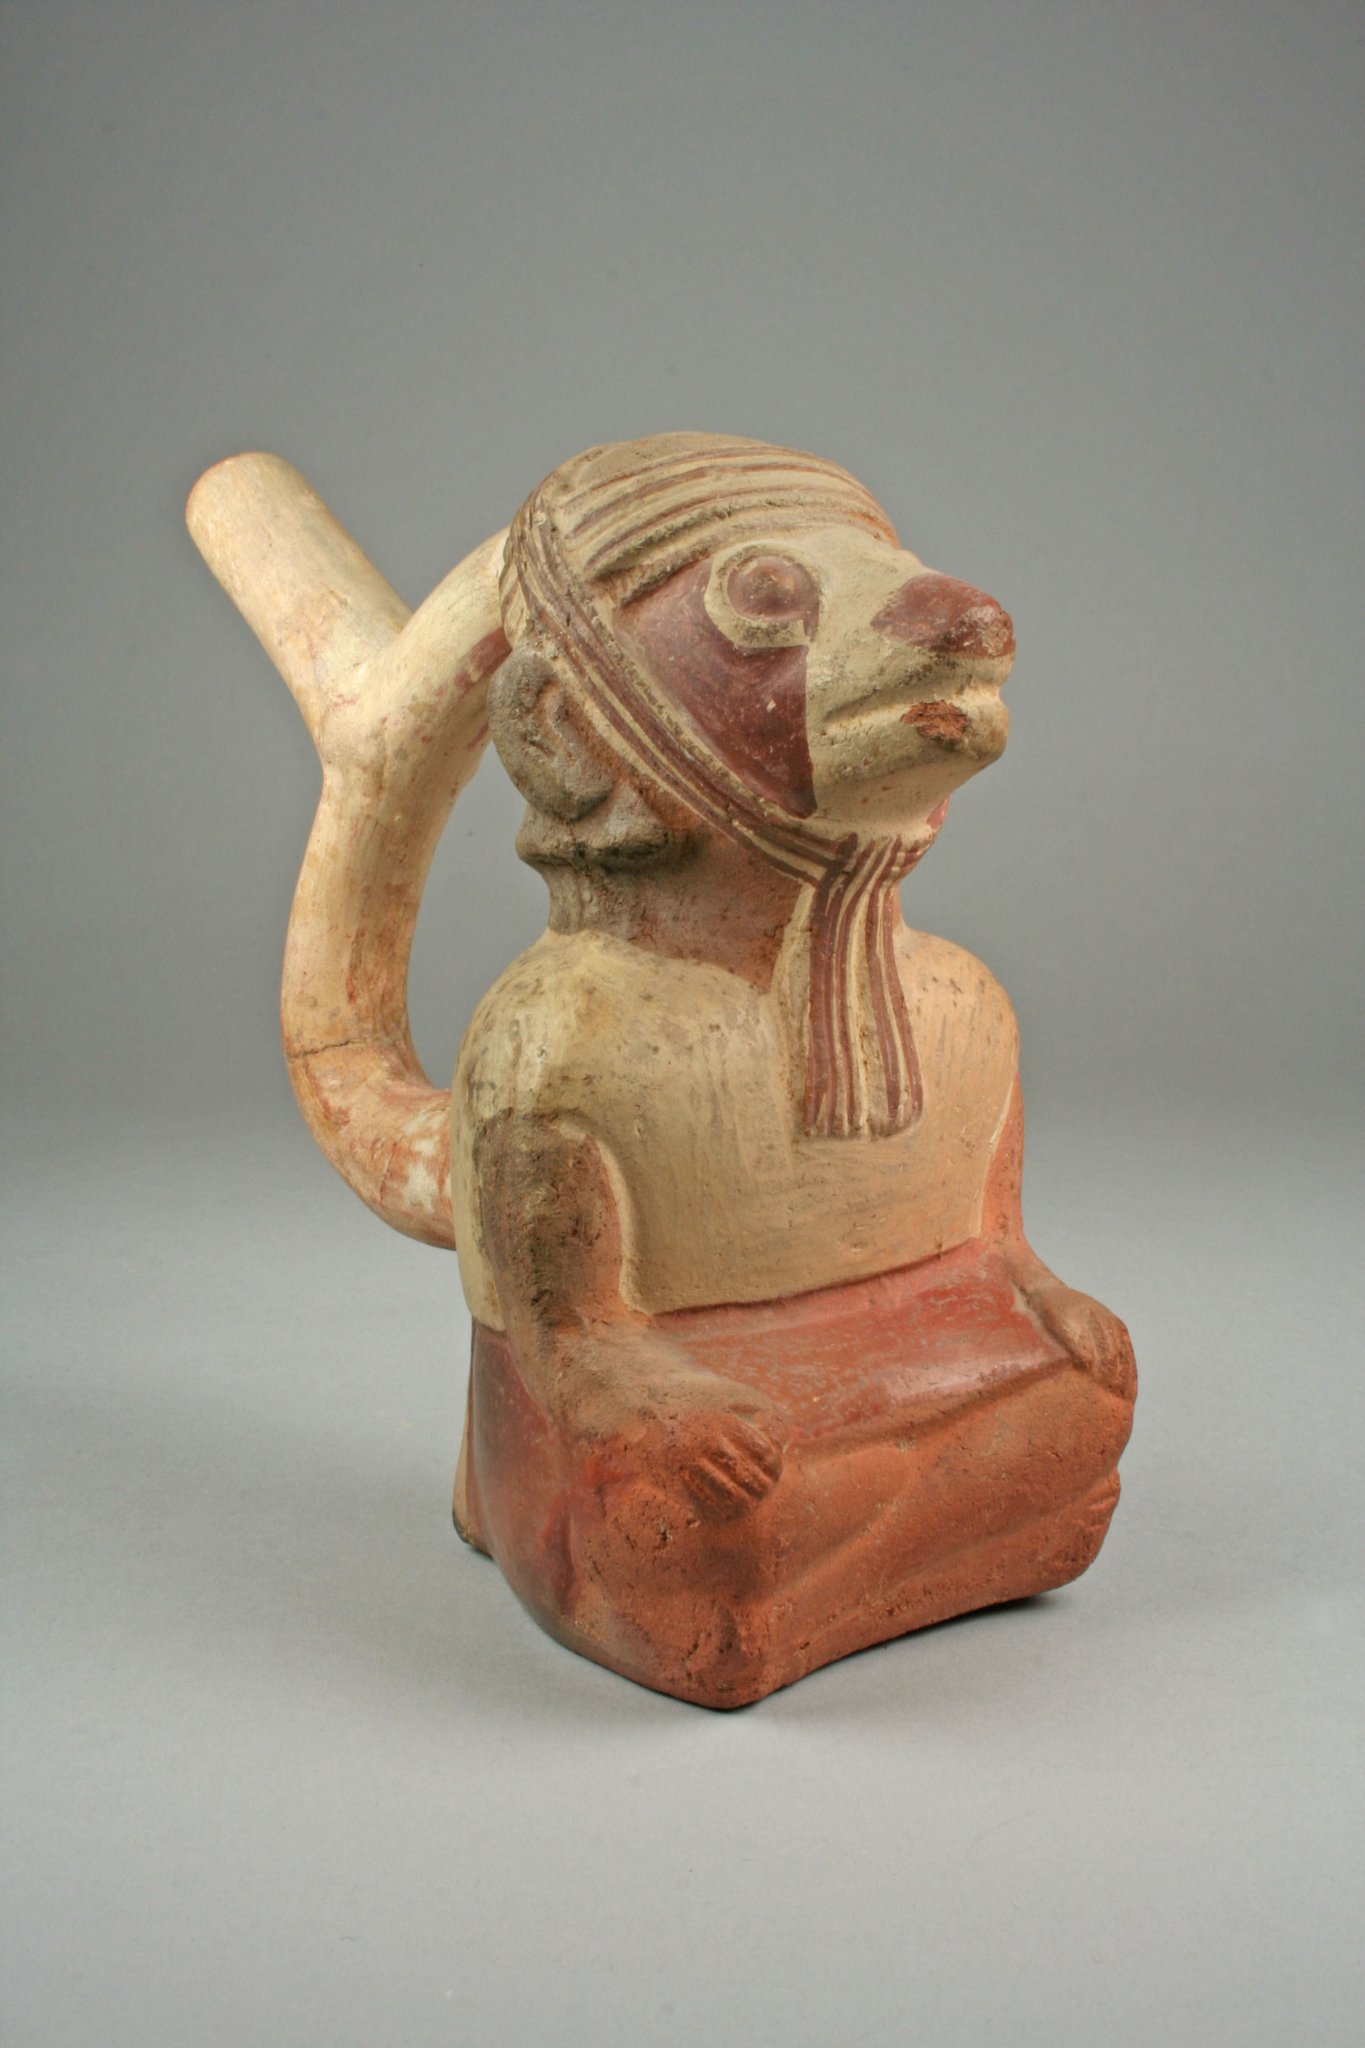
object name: bottle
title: Spectacled Bear Bottle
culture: moche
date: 401-700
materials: ceramic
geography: peru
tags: foxes